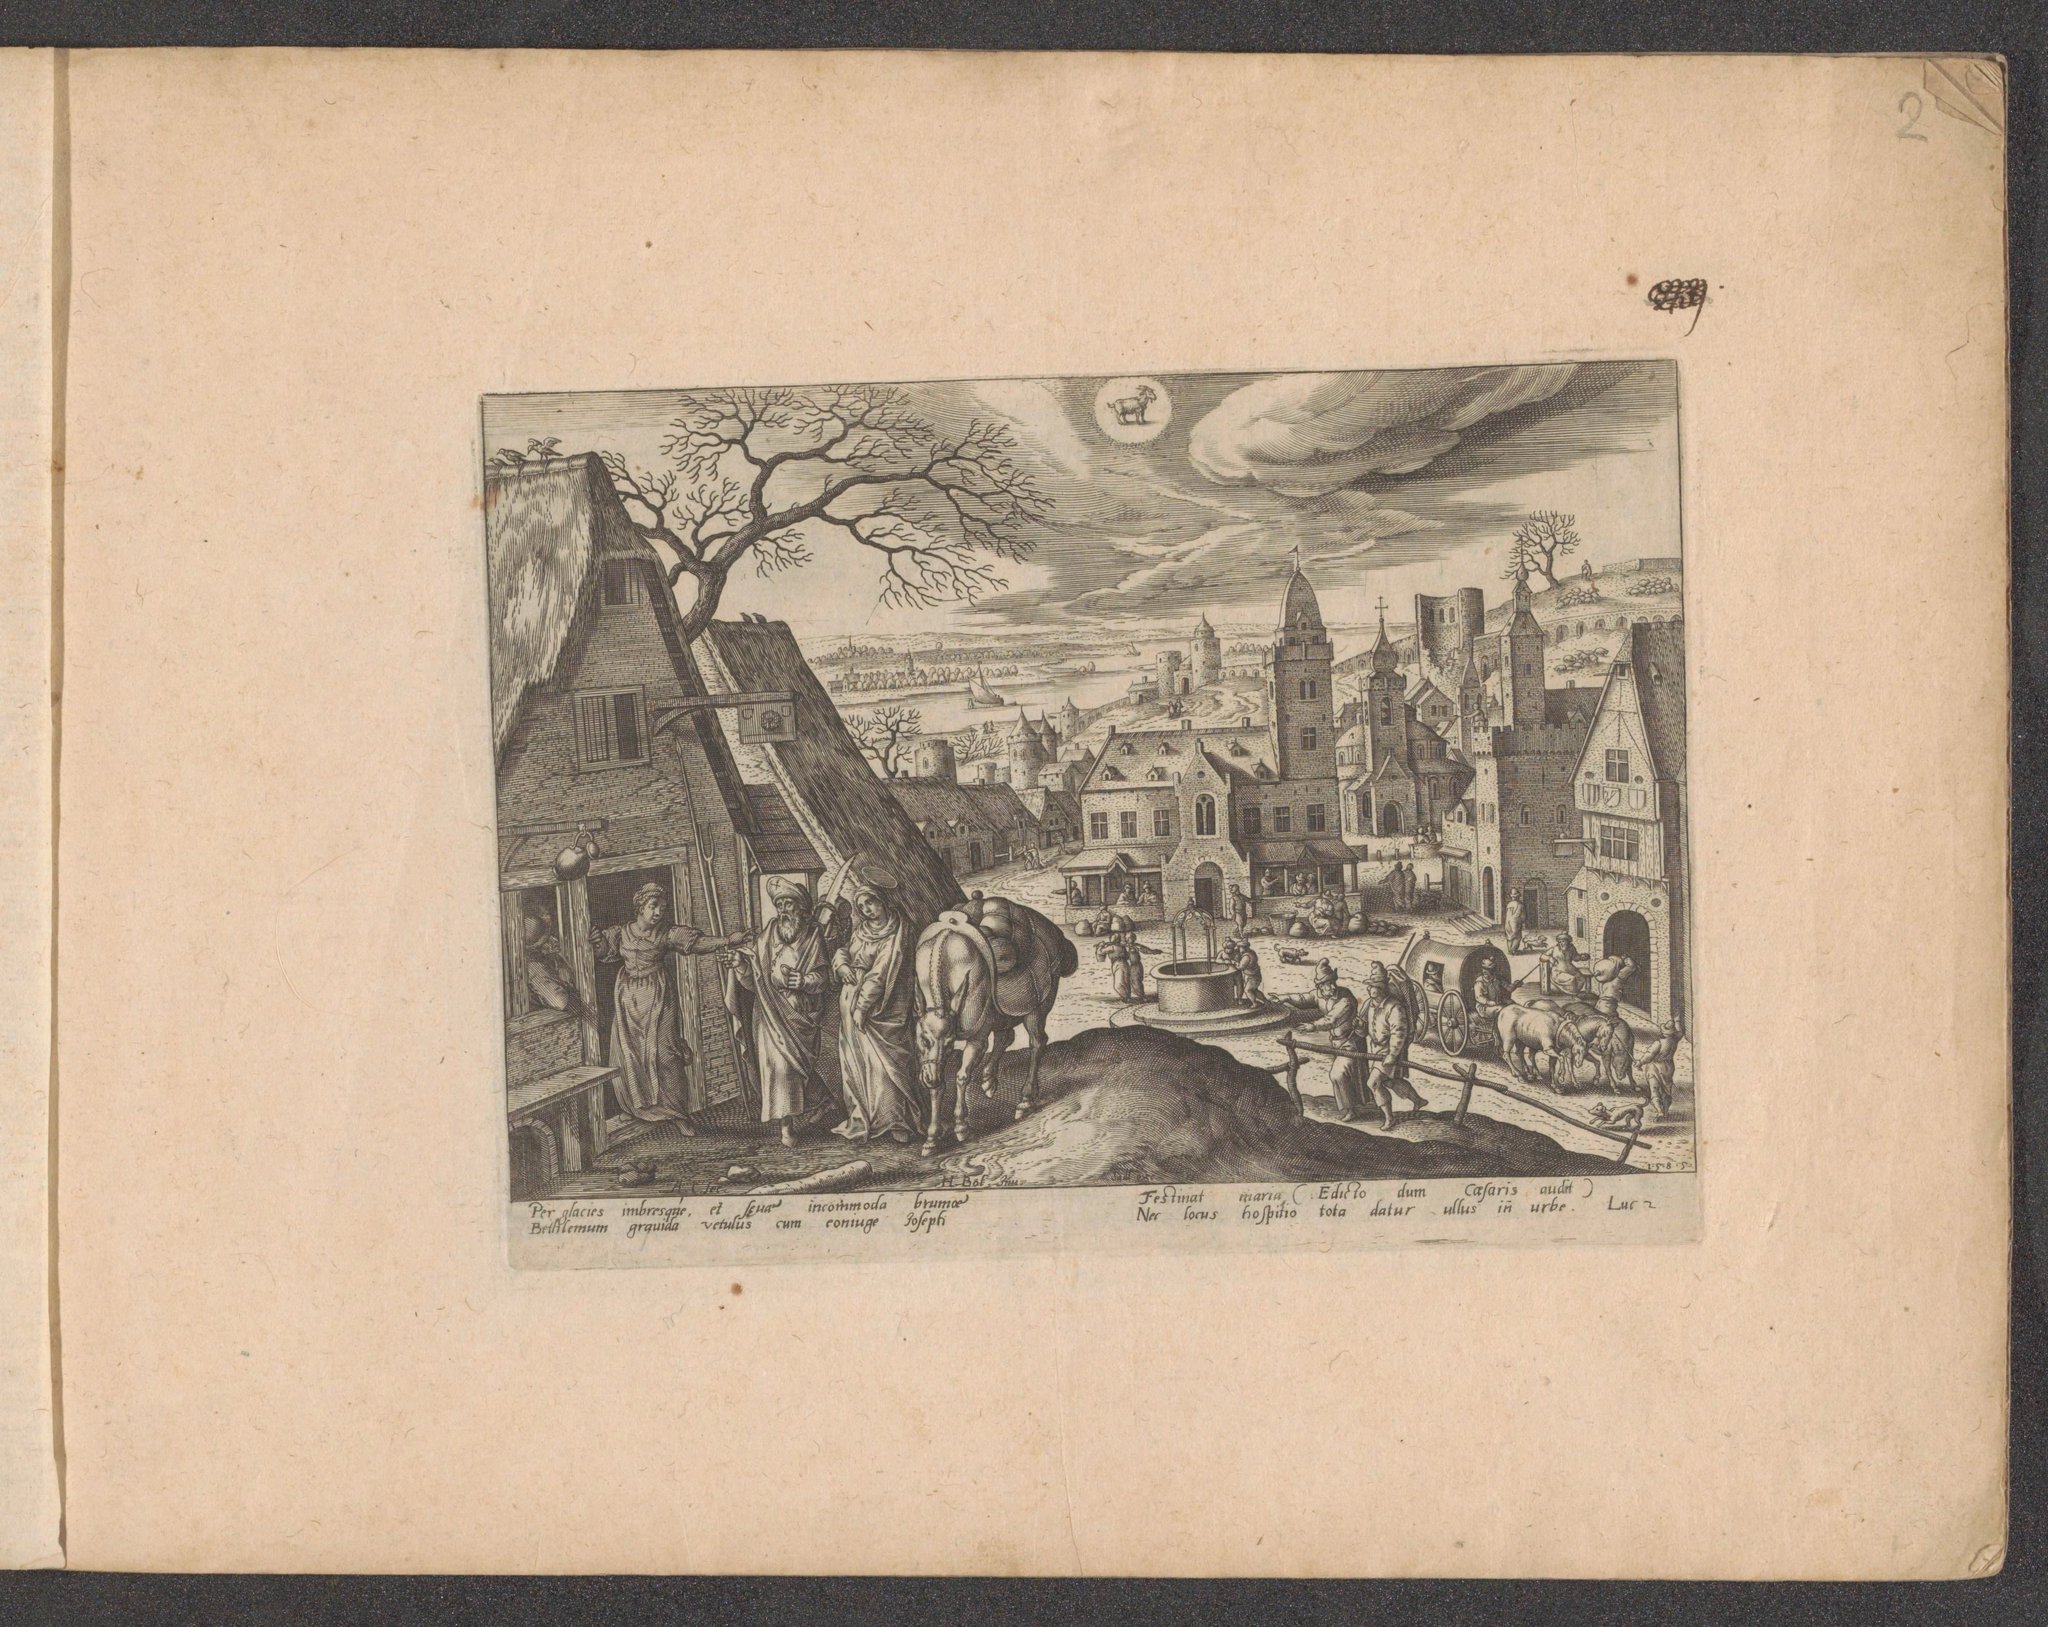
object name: print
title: December: Jozef en Maria worden geweigerd bij de herberg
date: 1585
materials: paper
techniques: engraving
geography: antwerp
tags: landscape symbolizing december, well, capricorn (zodiacal sign of december), village square, place, mary and joseph are not admitted to the inn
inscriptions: date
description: Middenboven het teken van de dierenriem Steenbok. Linksonder kloppen Maria en Jozef aan bij de herberg, waar voor hun geen plaats is. Daarachter een marktplein met waterput en paard en wagen. Vier regels Latijn in twee kolommen onder de voorstelling (Luc. 2). De prent maakt deel uit van een album.